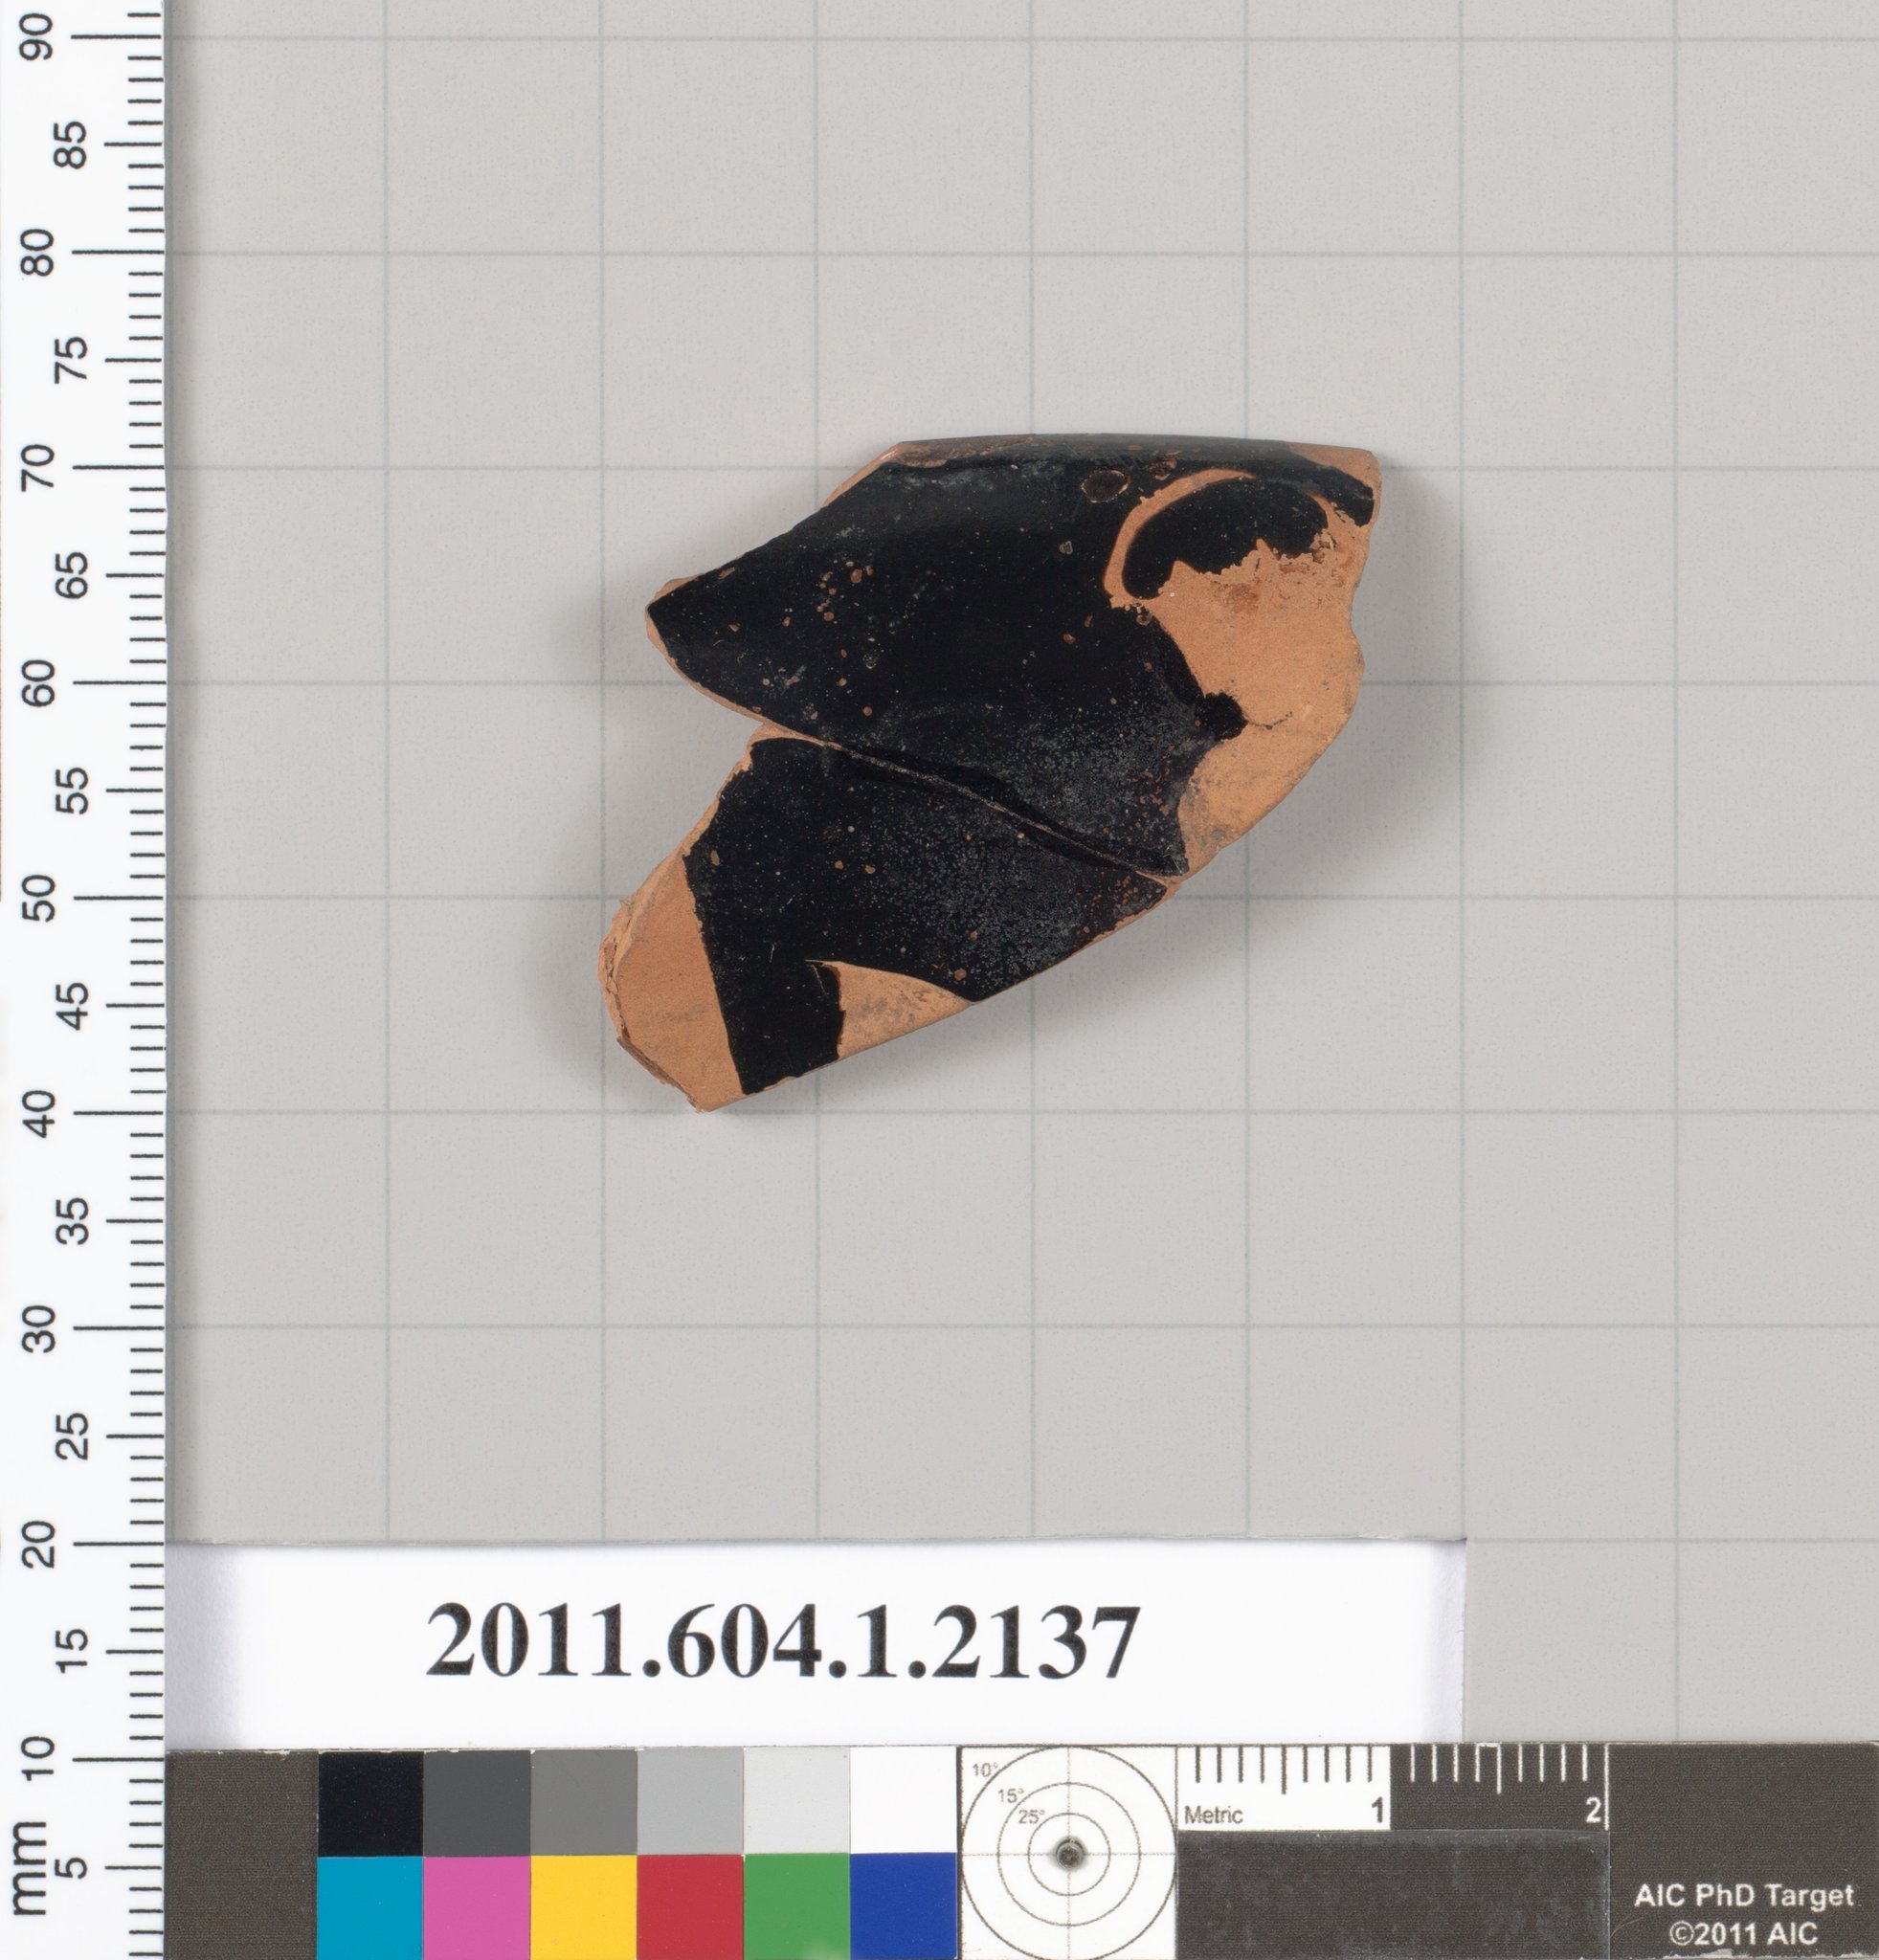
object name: kylix fragment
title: Terracotta rim fragment of a kylix (drinking cup)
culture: greek, attic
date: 475-451 BCE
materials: terracotta